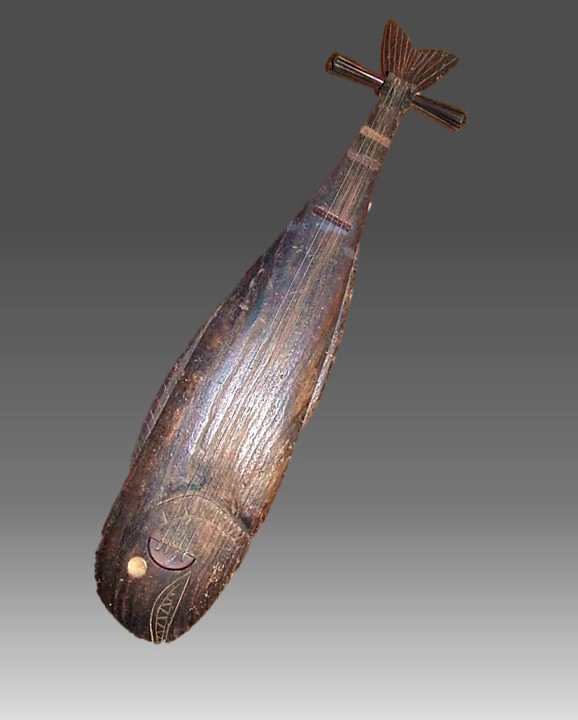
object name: mōsō biwa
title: Mōsō Biwa (盲僧琵琶)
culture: japanese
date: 1801-1900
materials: silk, wood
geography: japan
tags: fish